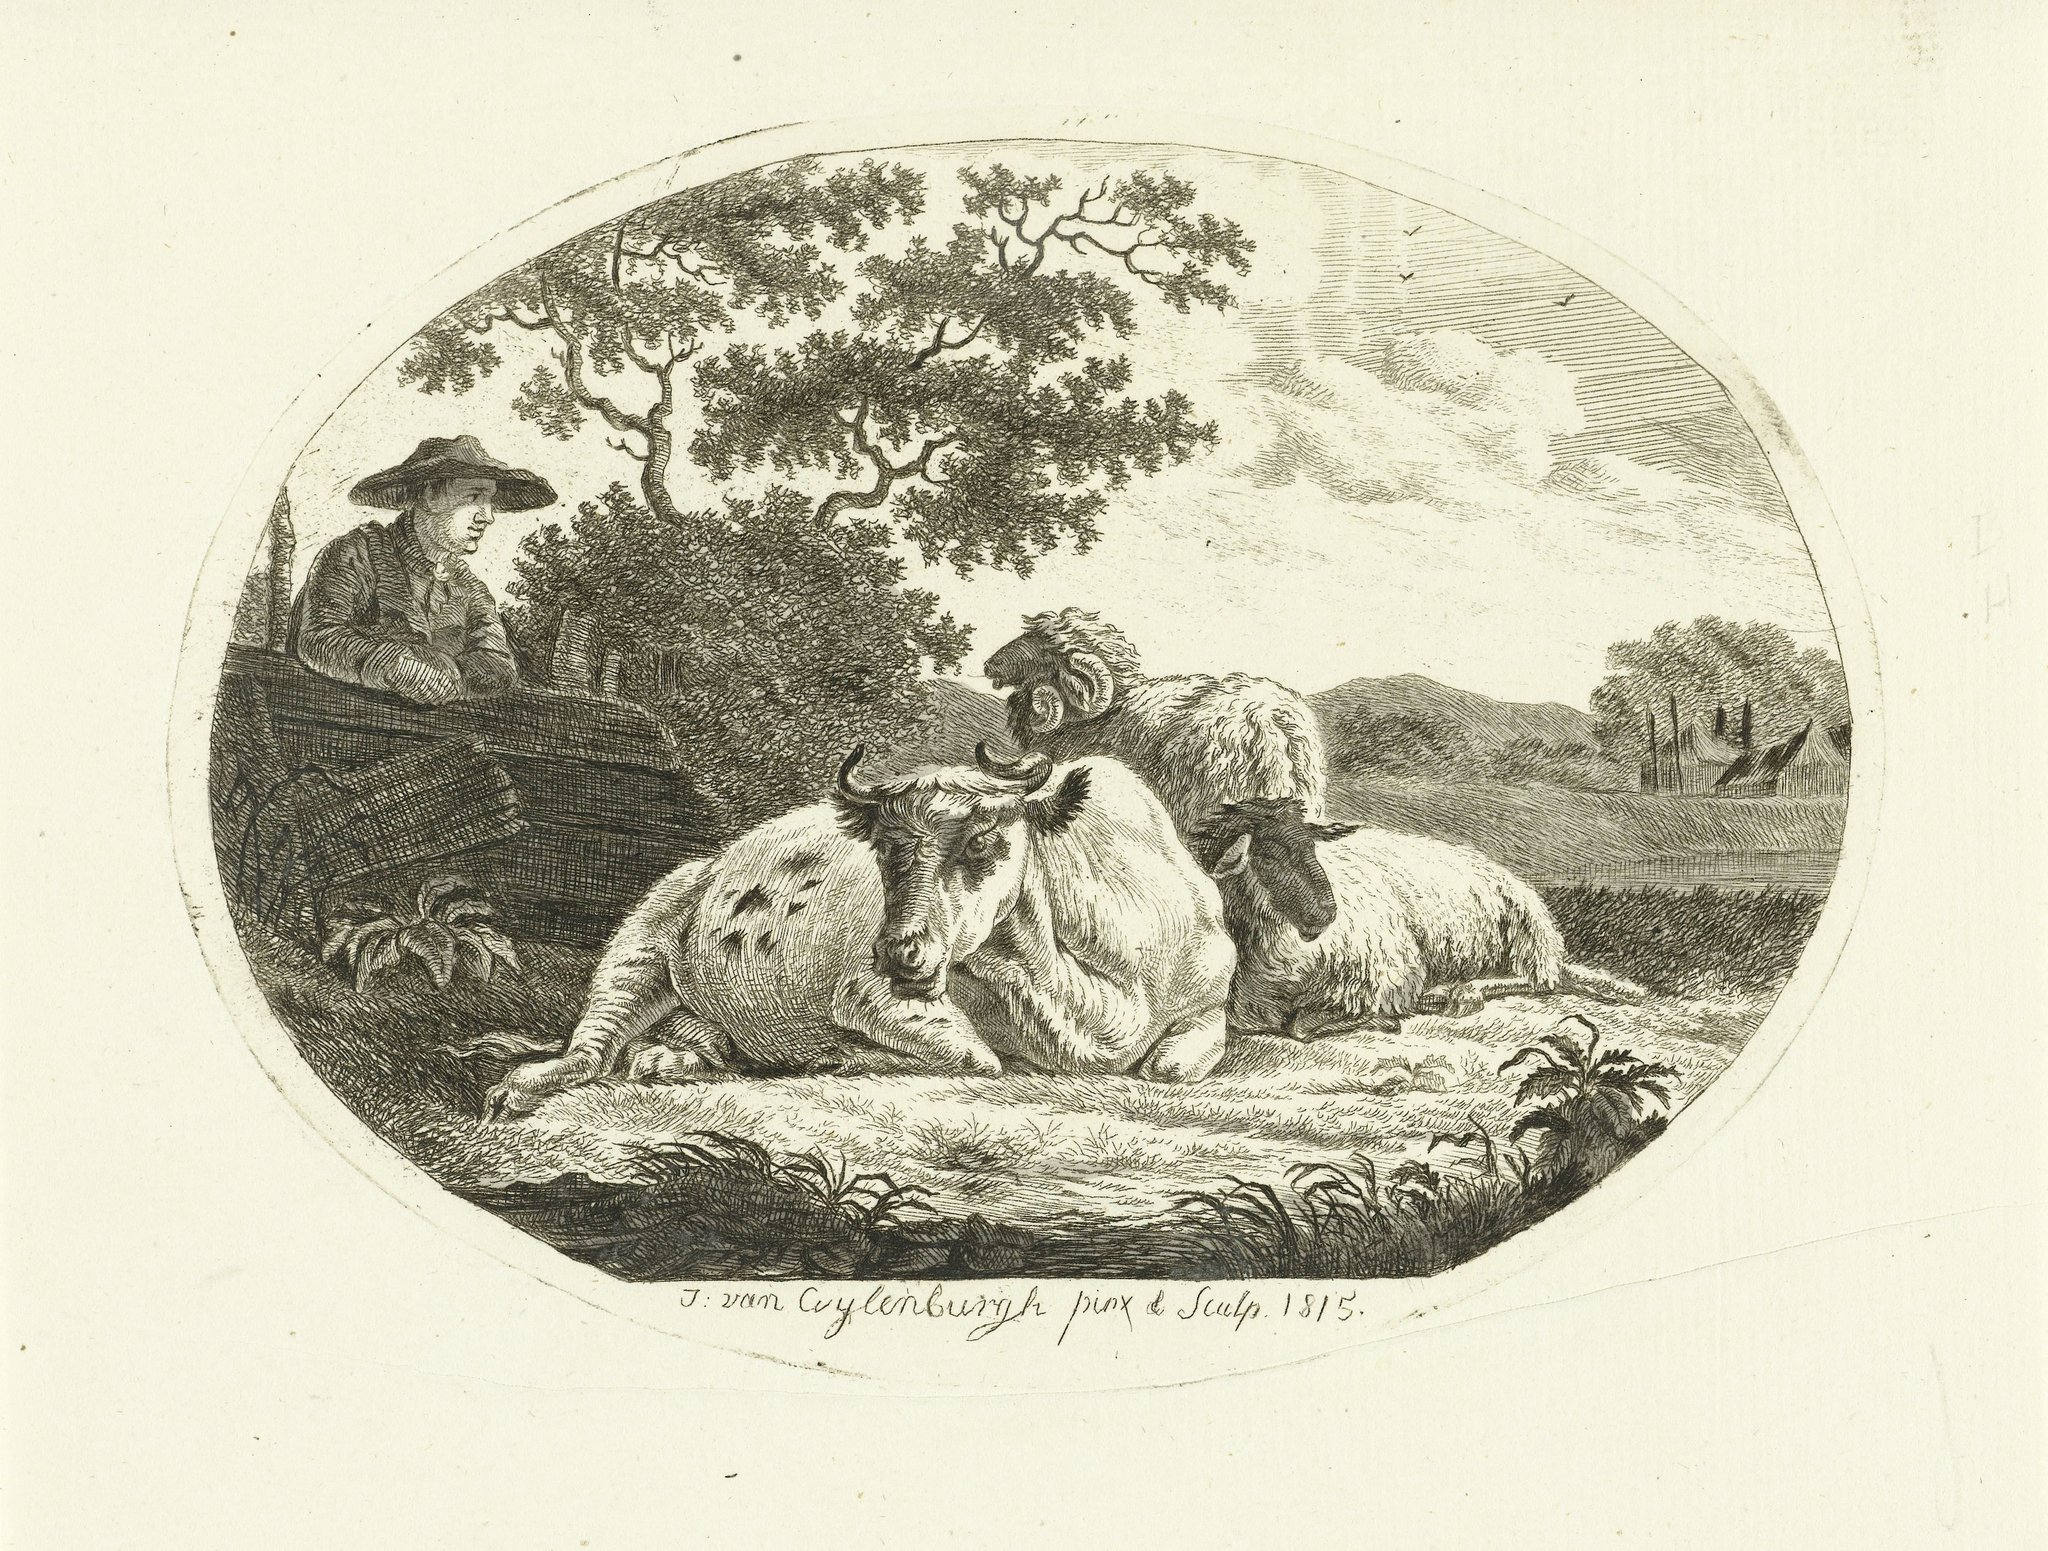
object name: print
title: Koe, schaap en ram in weide en boer leunend op hek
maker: johannes van cuylenburgh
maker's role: print maker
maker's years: 1793-1841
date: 1815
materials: paper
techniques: etching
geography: netherlands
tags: cow, farmers, sheep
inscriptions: collector's mark: Lugt 2228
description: Prent naar eigen schilderij van Johannes van Cuylenburgh.